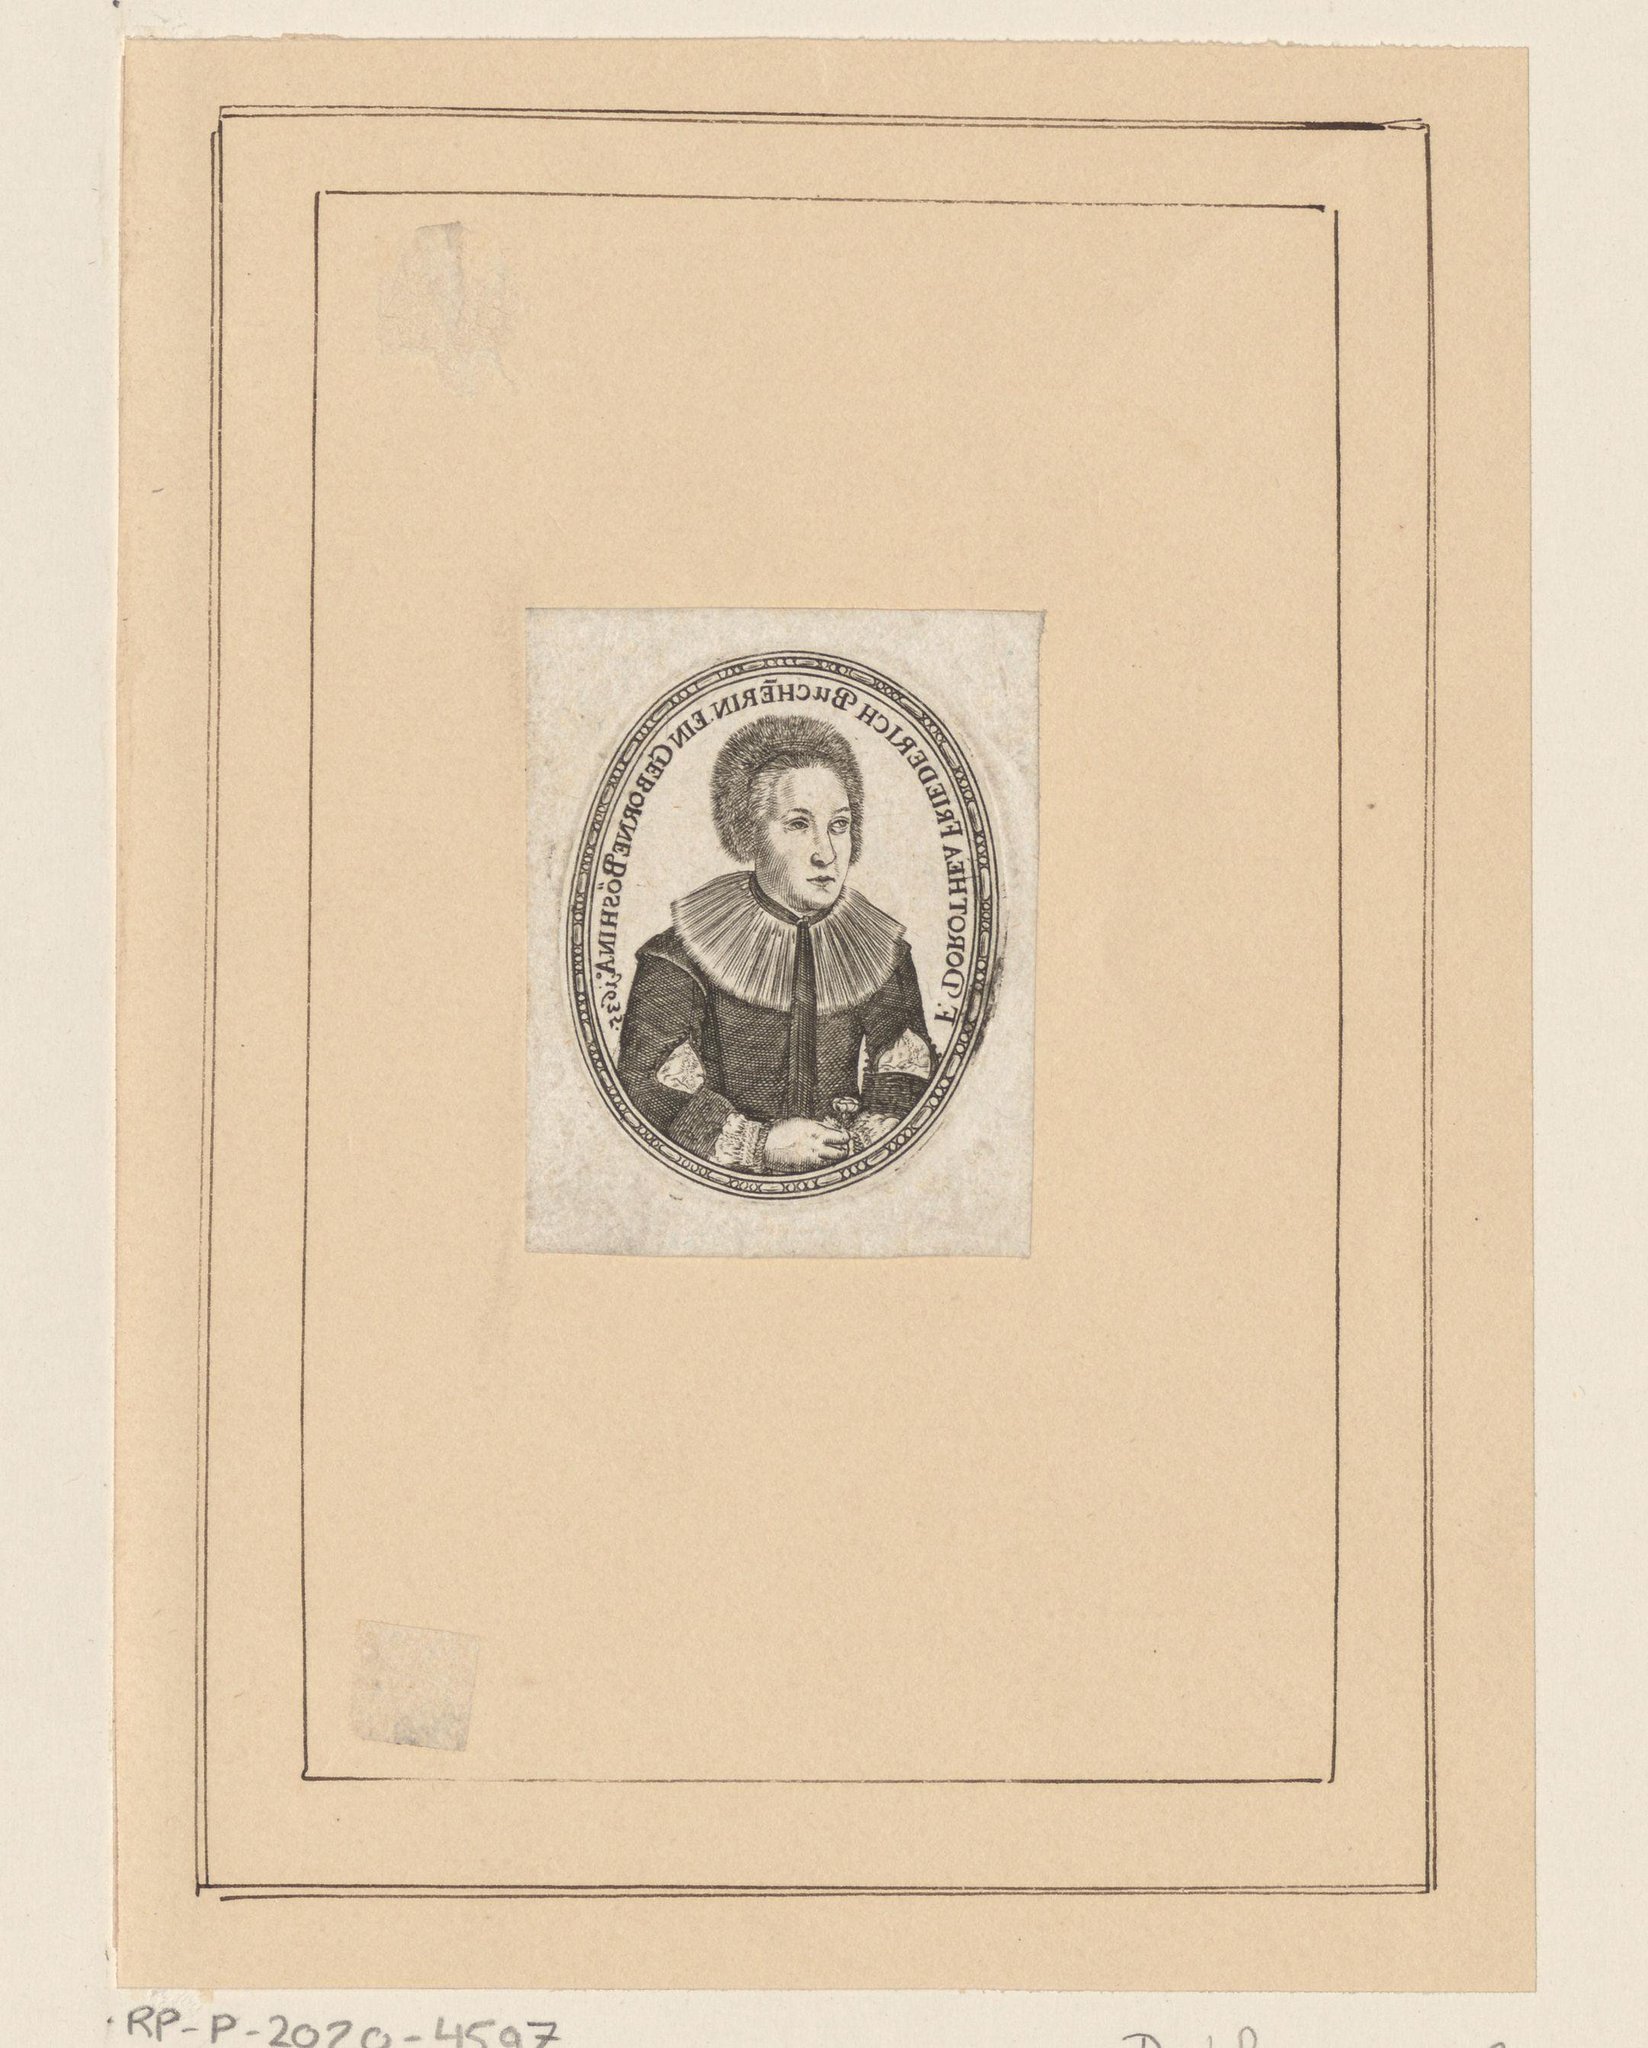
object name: print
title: Portret van Dorothea Buchner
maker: Anonymous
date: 1635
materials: paper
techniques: engraving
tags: historical persons - bb - woman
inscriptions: date